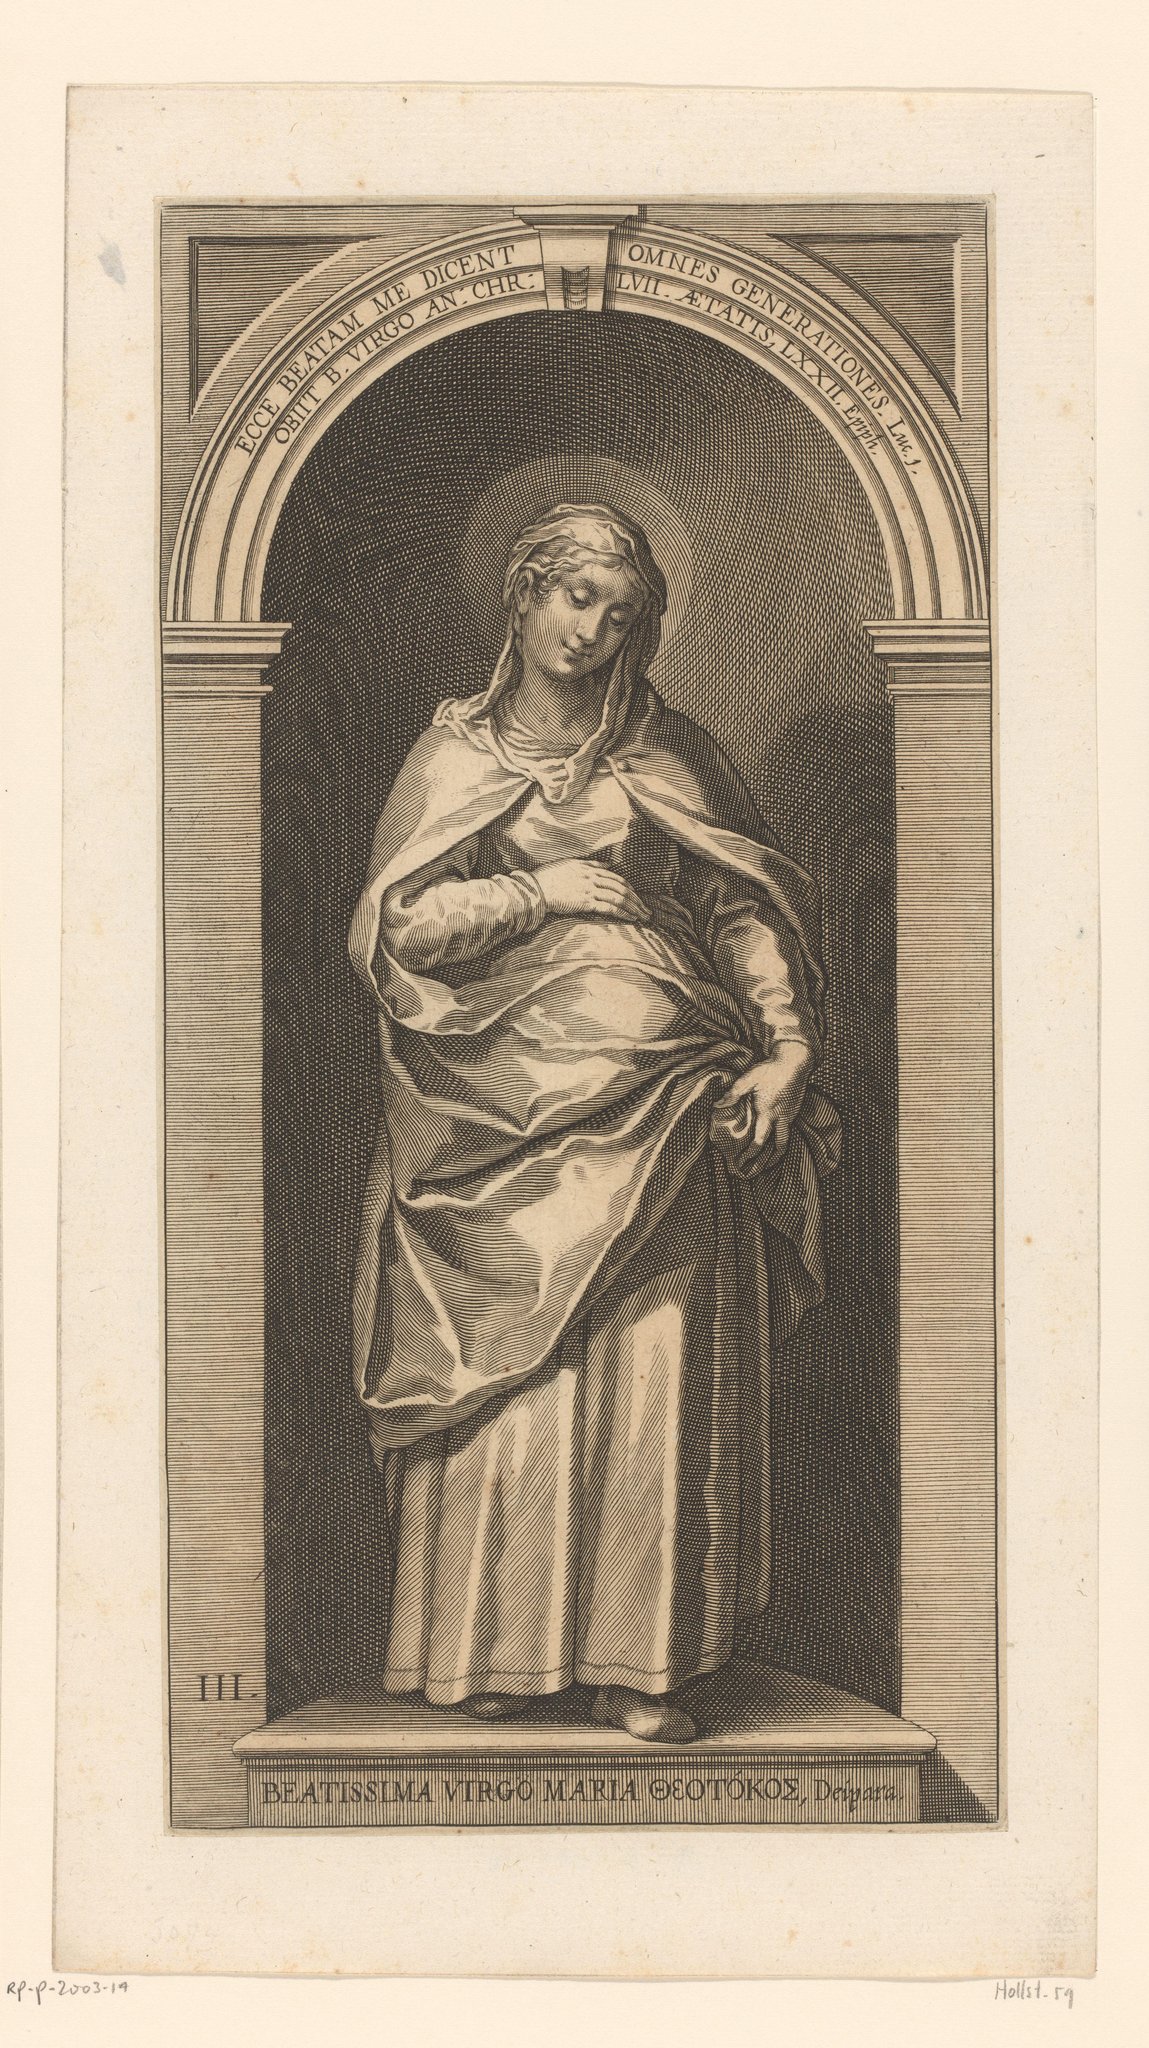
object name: print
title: Christelijk Heiligdom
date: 1623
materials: paper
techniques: engraving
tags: pregnant mary, our lady of expectation, 'madonna del parto'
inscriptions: collector's mark: Lugt 2228, collector's mark: Lugt 567, collector's mark: Lugt 2760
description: Maria in verwachting van Christus. Tekst uit de Bijbelpassages Luc. 1 en Epiph. in het Latijn in de bogen van de nis.